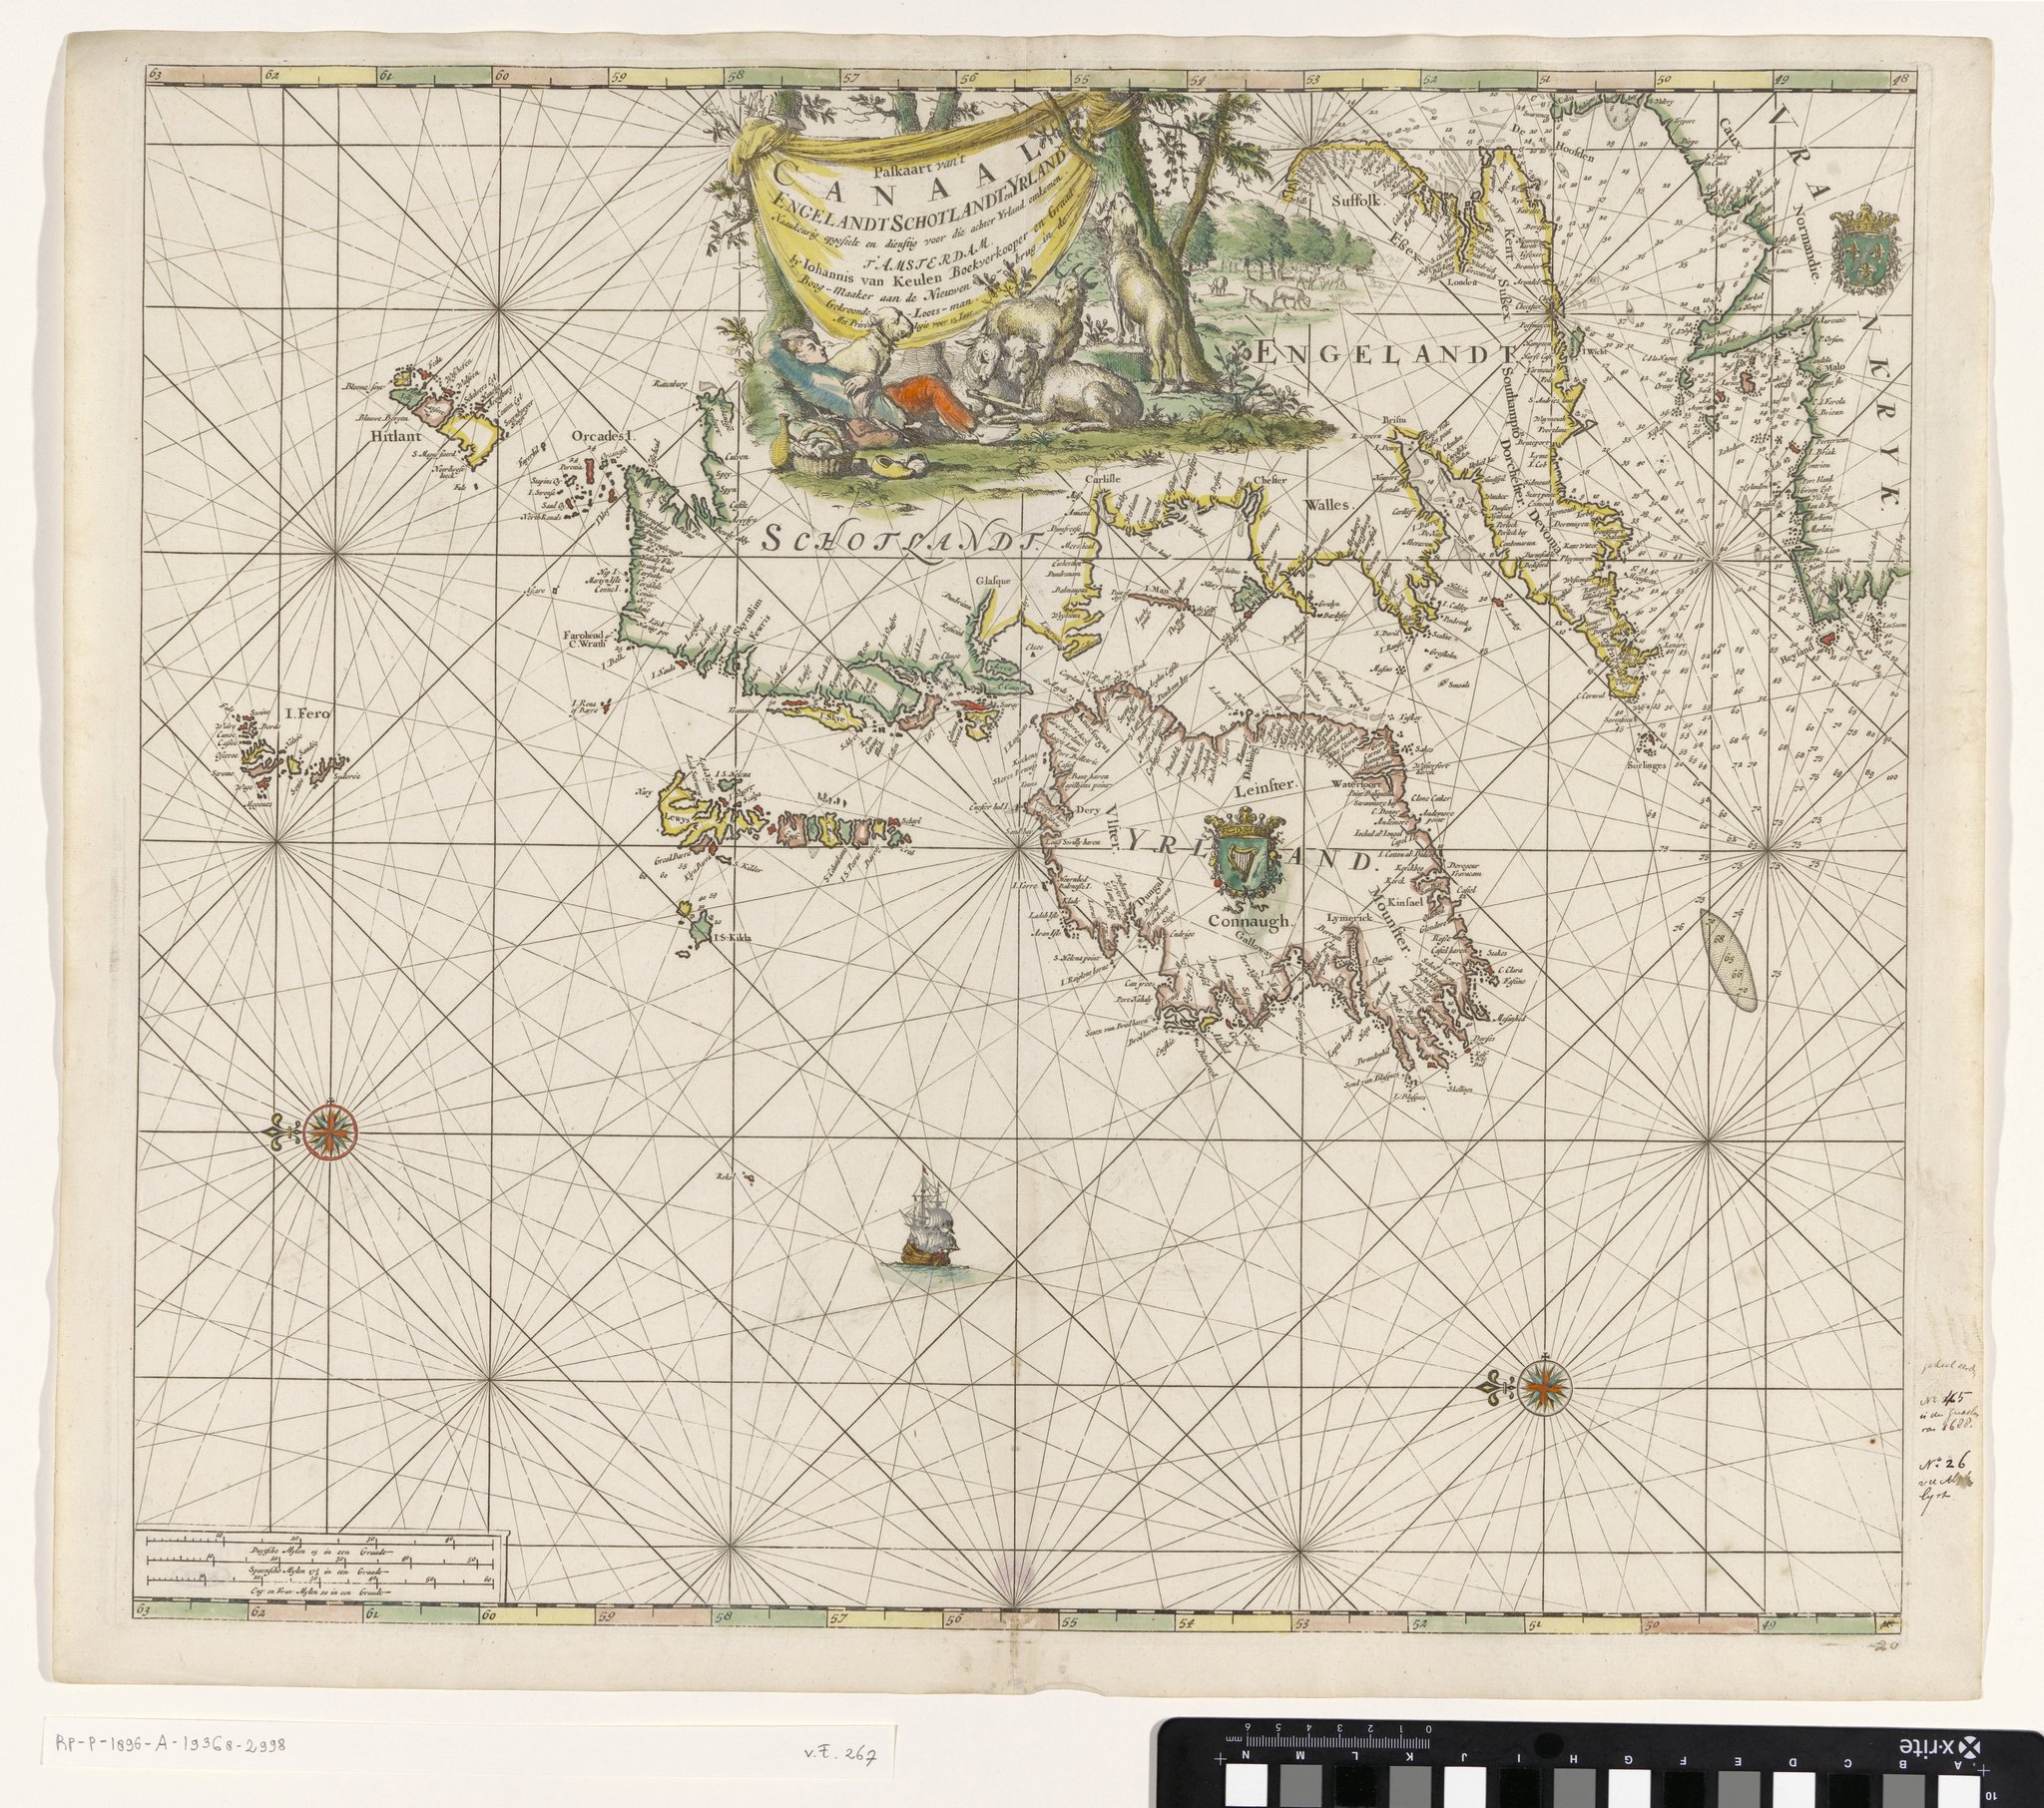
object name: print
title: Paskaart van de kusten van Engeland, Schotland en Ierland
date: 1682-1803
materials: paper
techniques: brush, etching, hand coloring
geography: amsterdam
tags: herding, herdsman, herdswoman, shepherd, shepherdess, cowherd, etc., sheep, sleeping on the ground, france, england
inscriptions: collector's mark: Lugt 2228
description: Paskaart van de kusten van Engeland, Schotland, Ierland en Frankrijk. Met twee kompasrozen, het Noorden ligt links. Midden boven een vignet met de titel en een schaapsherder dit onder de boom ligt te slapen. Linksonder de schaal in Duitse, Spaanse en Engelse of Franse mijlen.